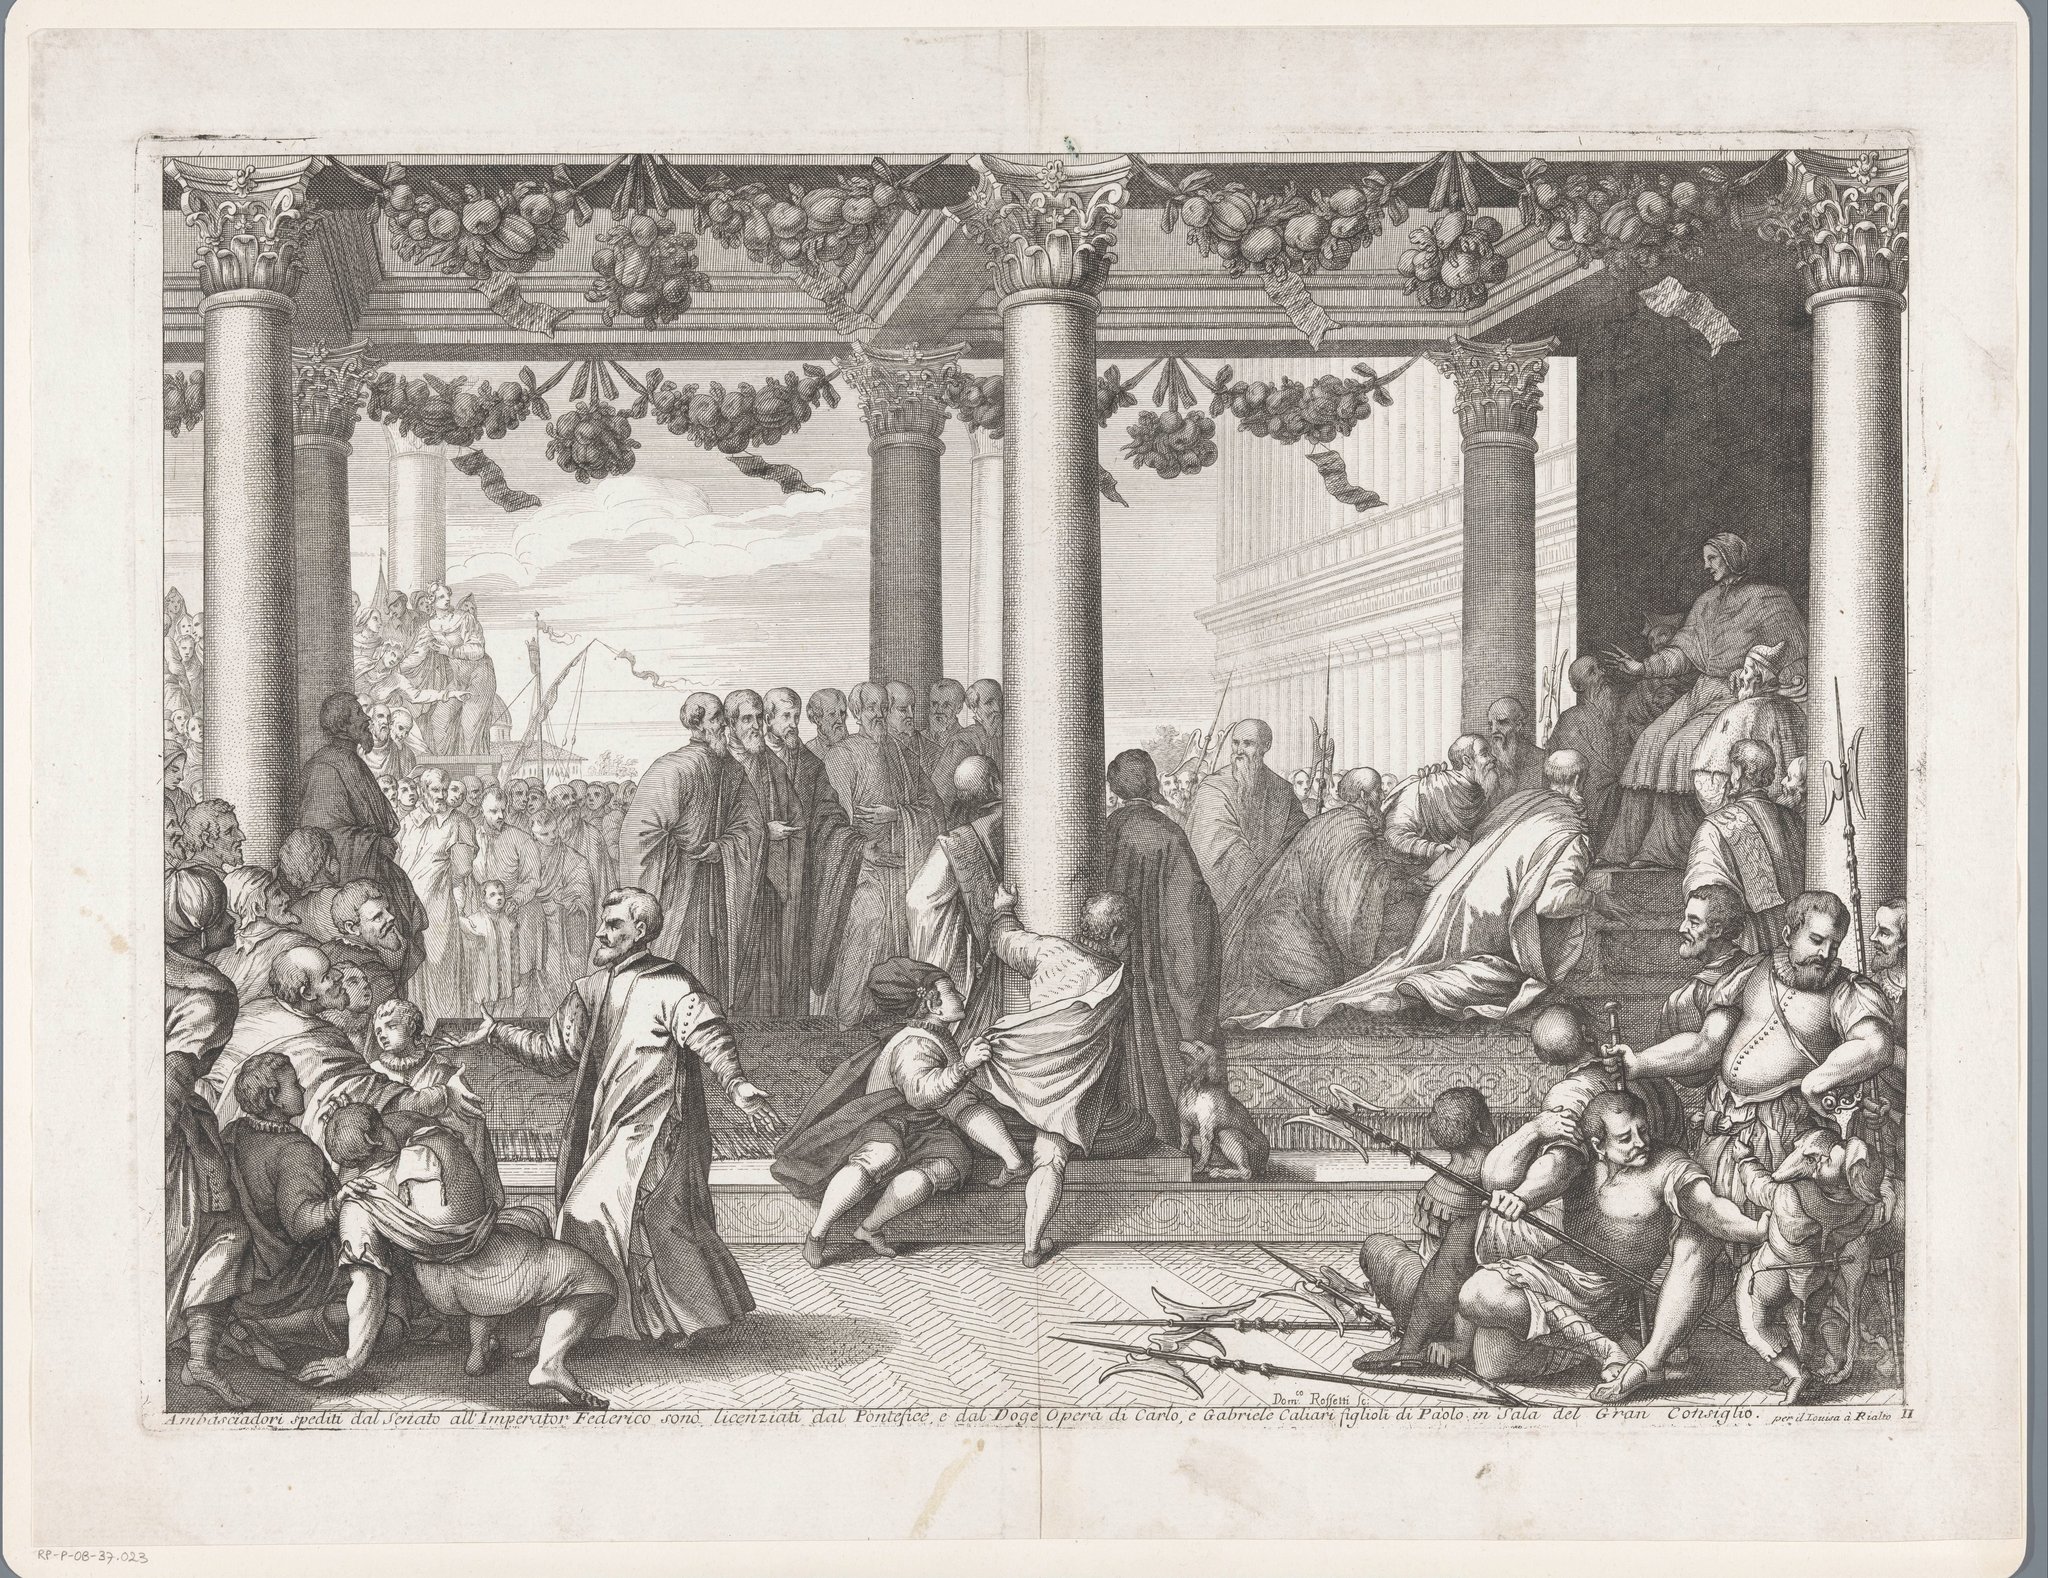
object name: print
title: Il gran Teatro di Venezia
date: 1660-1736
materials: paper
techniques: engraving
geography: venice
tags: ambassador, other sovereign: doge, venice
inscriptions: inscription: ‘f 1,50’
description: Gezicht in een galerij met rechts de bisschop en de doge van Venetië. Voor hen staan en knielen ambassadeurs. Op de voorgrond rechts een groep soldaten. Op de voorgrond links een groep toeschouwers. Titel in het Italiaans in ondermarge.